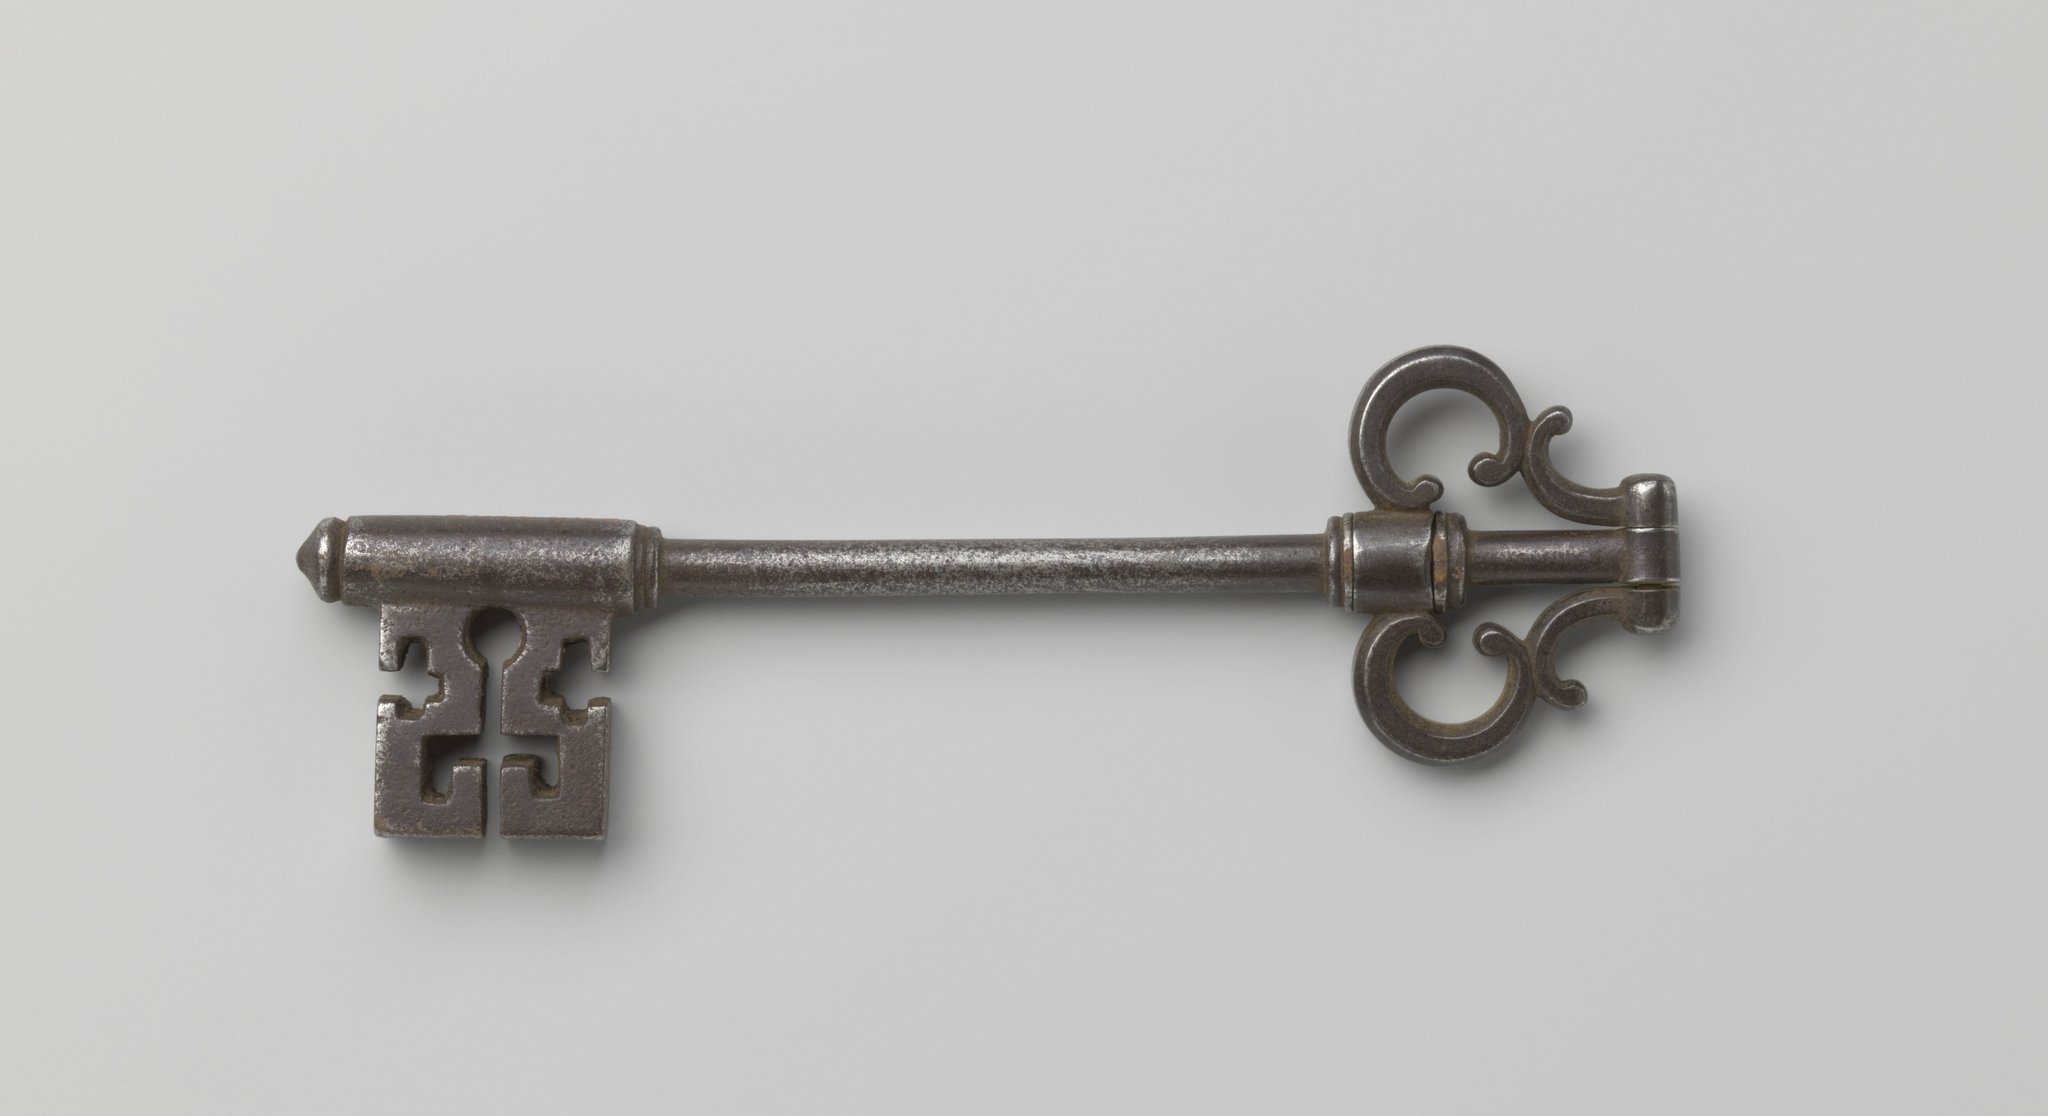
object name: key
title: Sleutel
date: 1800-1900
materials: iron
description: Sleutel met opklapbare greep. Deze wordt gevormd door twee toegewende C-voluten, een halve cylinder insluitend, die in neergeklapte toestand om een verdikking van de schacht past. De schacht, die bij de baard breder is, eindigt in een platte knop.